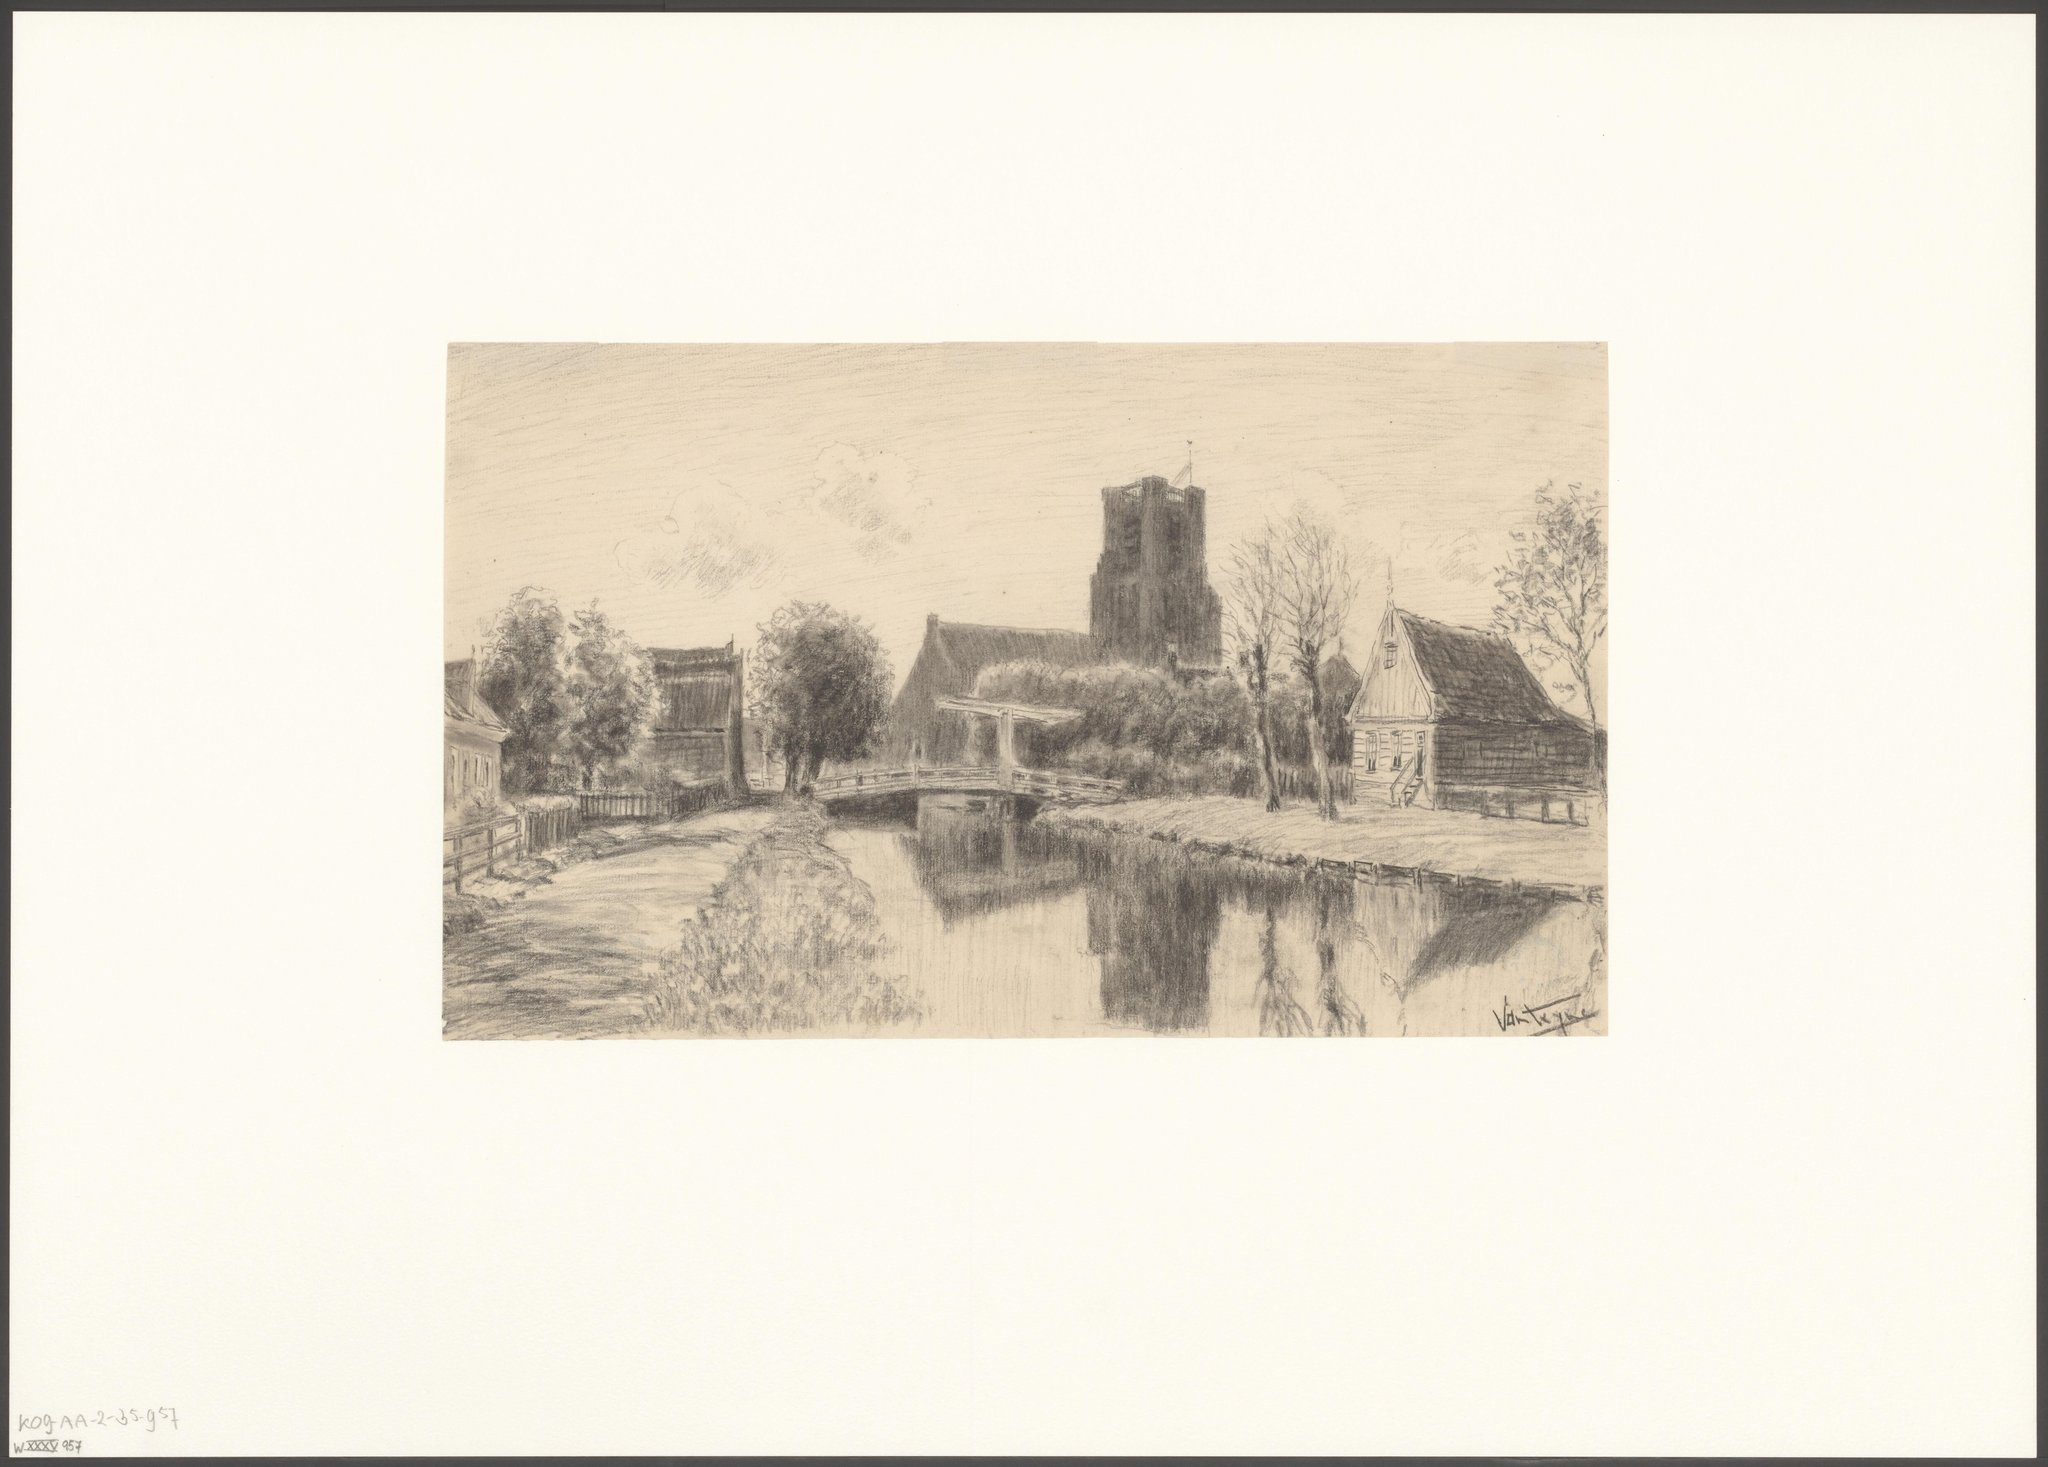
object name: drawing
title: Gezicht op Ransdorp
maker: anthonie van teijn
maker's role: draughtsman, painter, print maker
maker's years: 1863-1943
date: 1928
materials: chalk, paper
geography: amsterdam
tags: canal, village, church (exterior), bridge in village across river, canal, etc.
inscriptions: inscription: ‘Ransdorp. 1928.’, signature: ‘VanTeyne’, collector's mark: Lugt 800a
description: Tekening binnen de Atlas Van Eck ingedeeld op wijknummer 35.